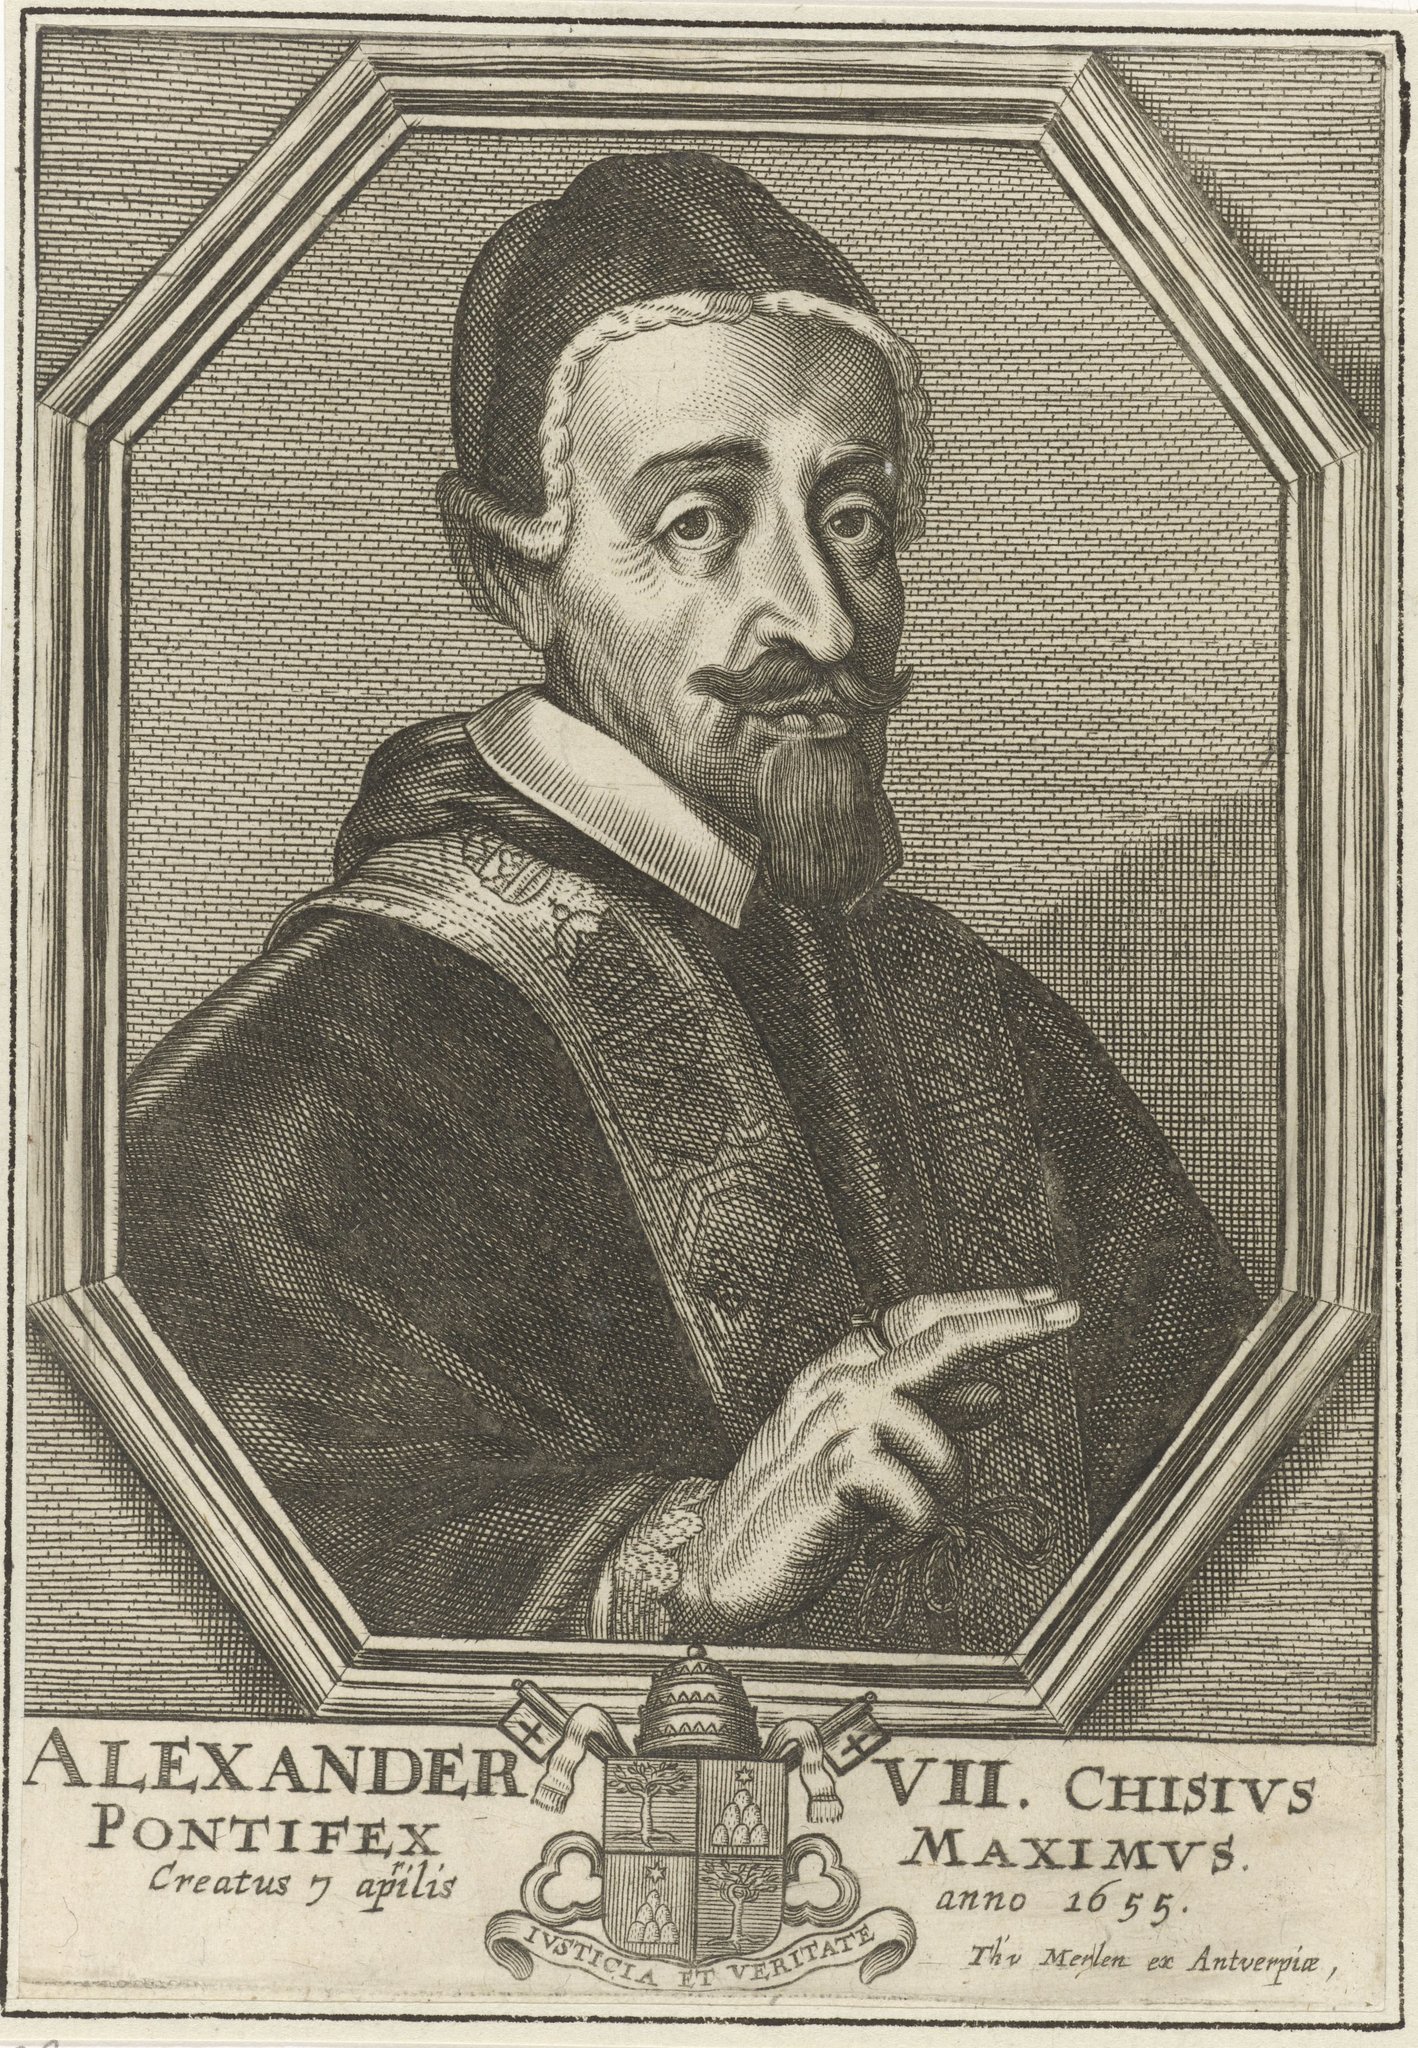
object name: print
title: Portret van paus Alexander VII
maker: theodor van merlen (ii)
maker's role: print maker, publisher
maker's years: 1609-1672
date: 1619-1672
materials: paper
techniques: engraving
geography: antwerp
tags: alexander vii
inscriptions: collector's mark: Lugt 2228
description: Portret van paus Alexander VII, gekleed in het pauselijk gewaad, het hoofd getooid met een camauro. Midden onder zijn pauselijk wapen.